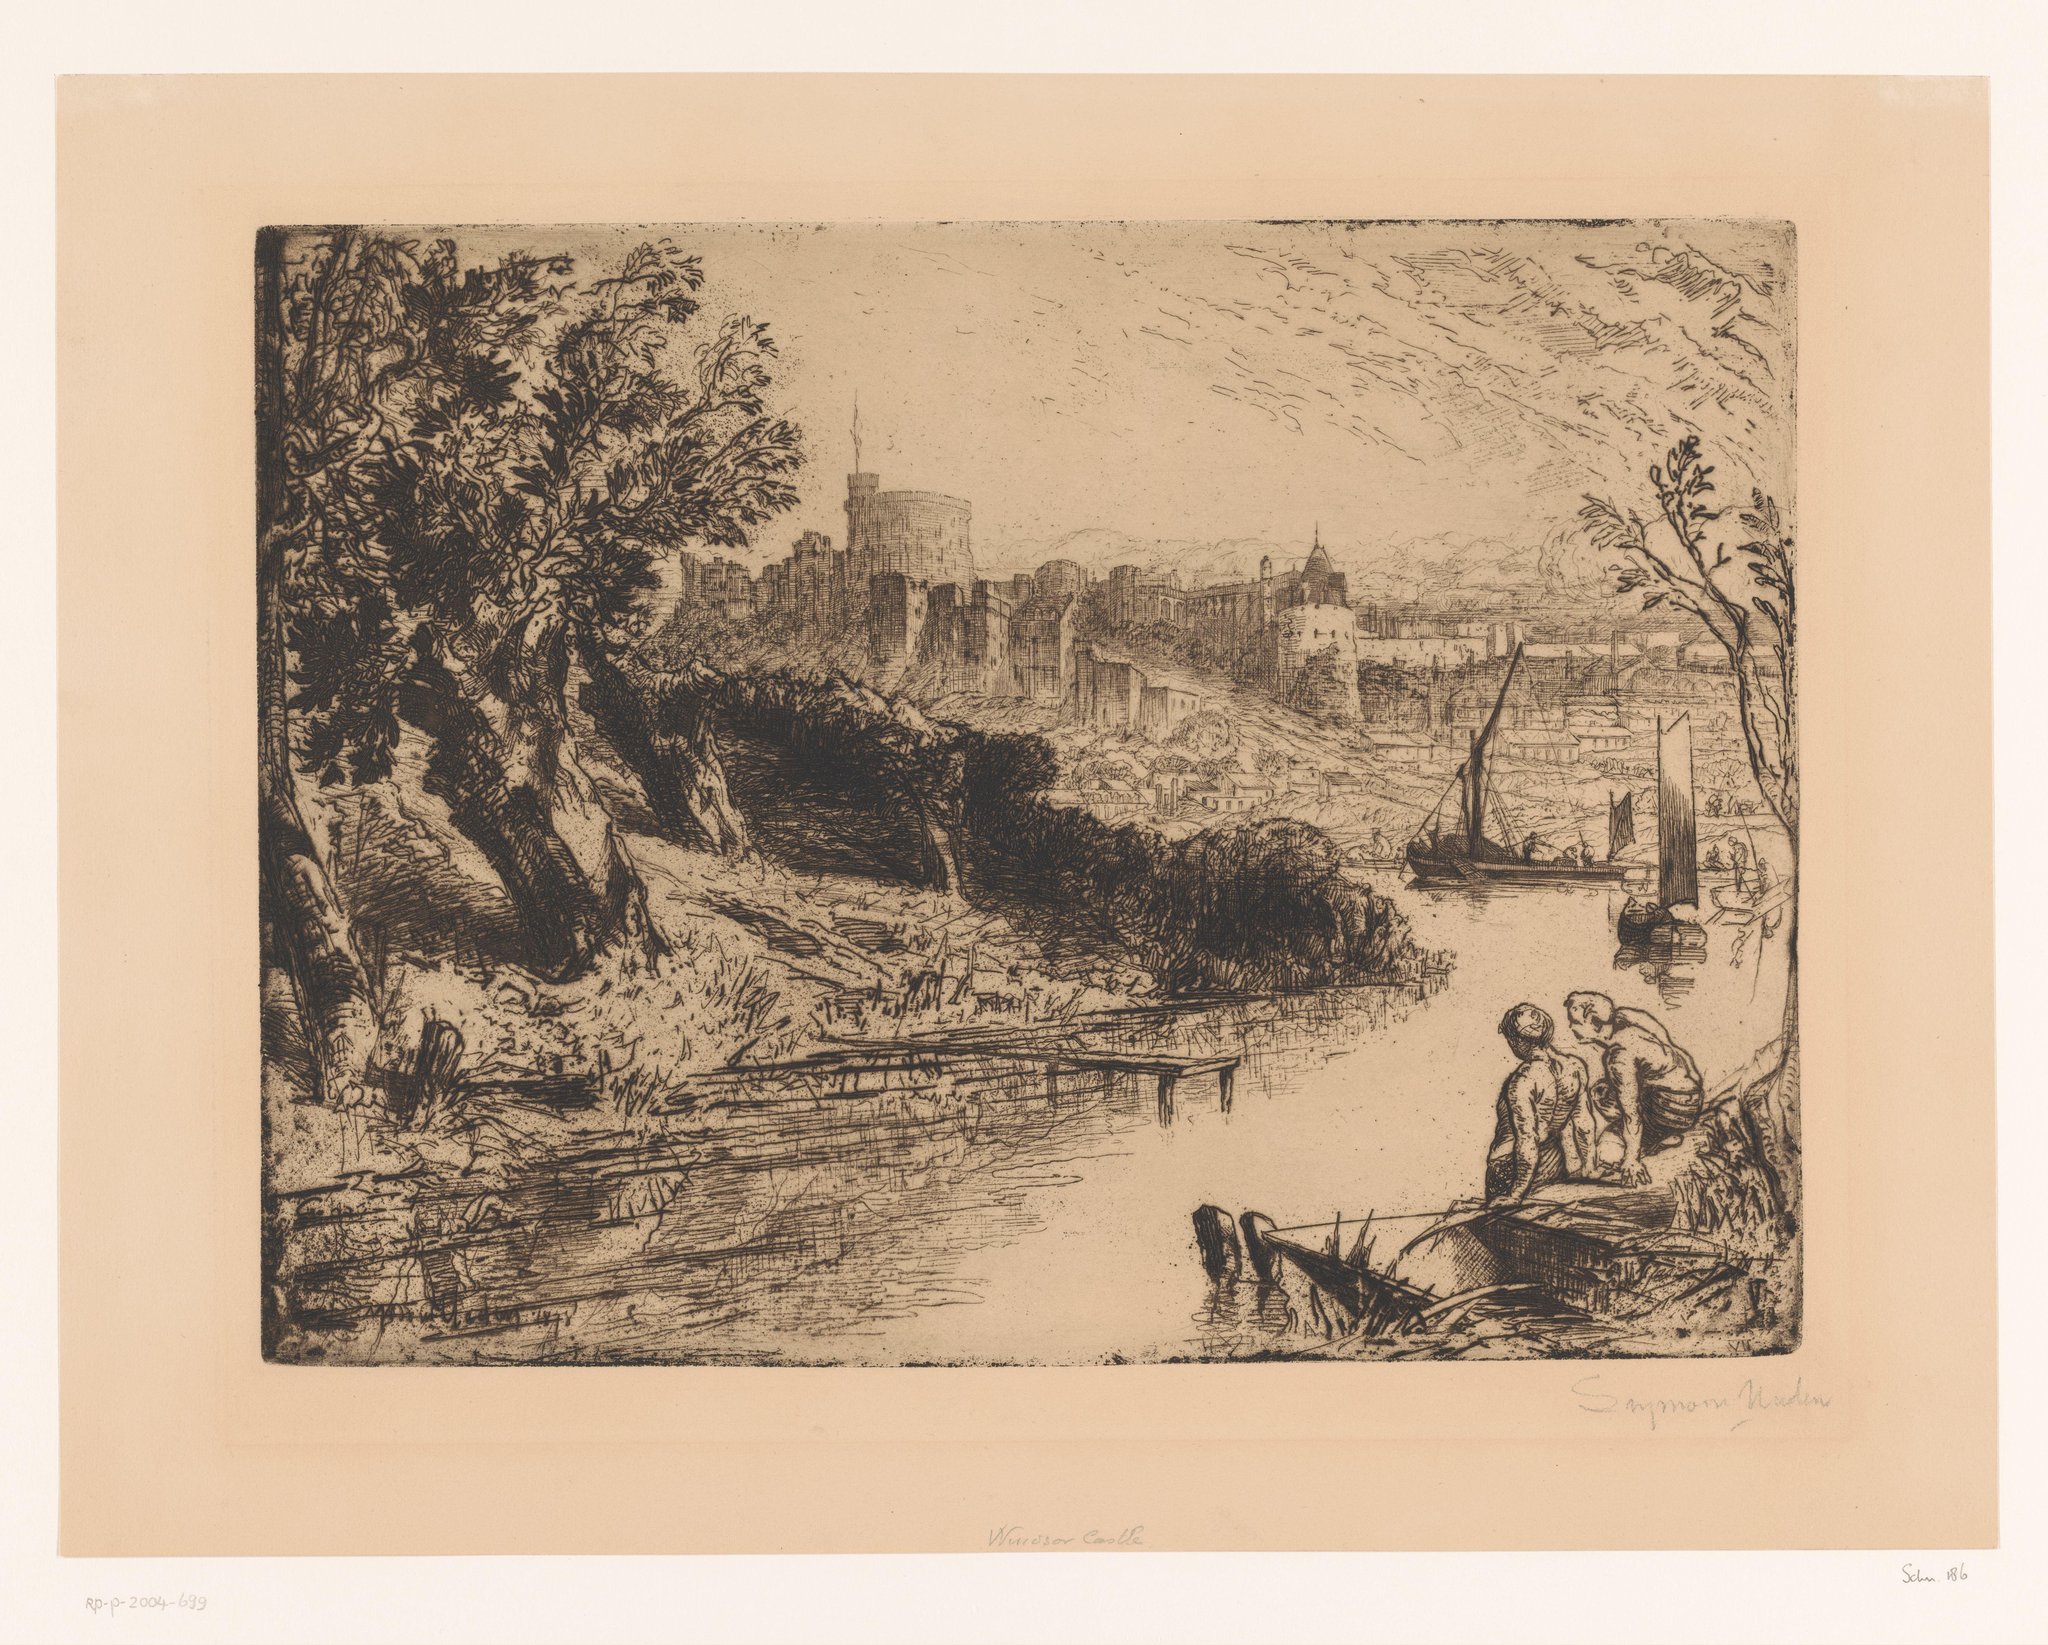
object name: print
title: Gezicht op Windsor Castle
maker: francis seymour-haden (sir)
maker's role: print maker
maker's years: 1818-1910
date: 1878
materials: paper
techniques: drypoint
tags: castle, river (+ landscape with figures, staffage)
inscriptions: collector's mark: Lugt 2228